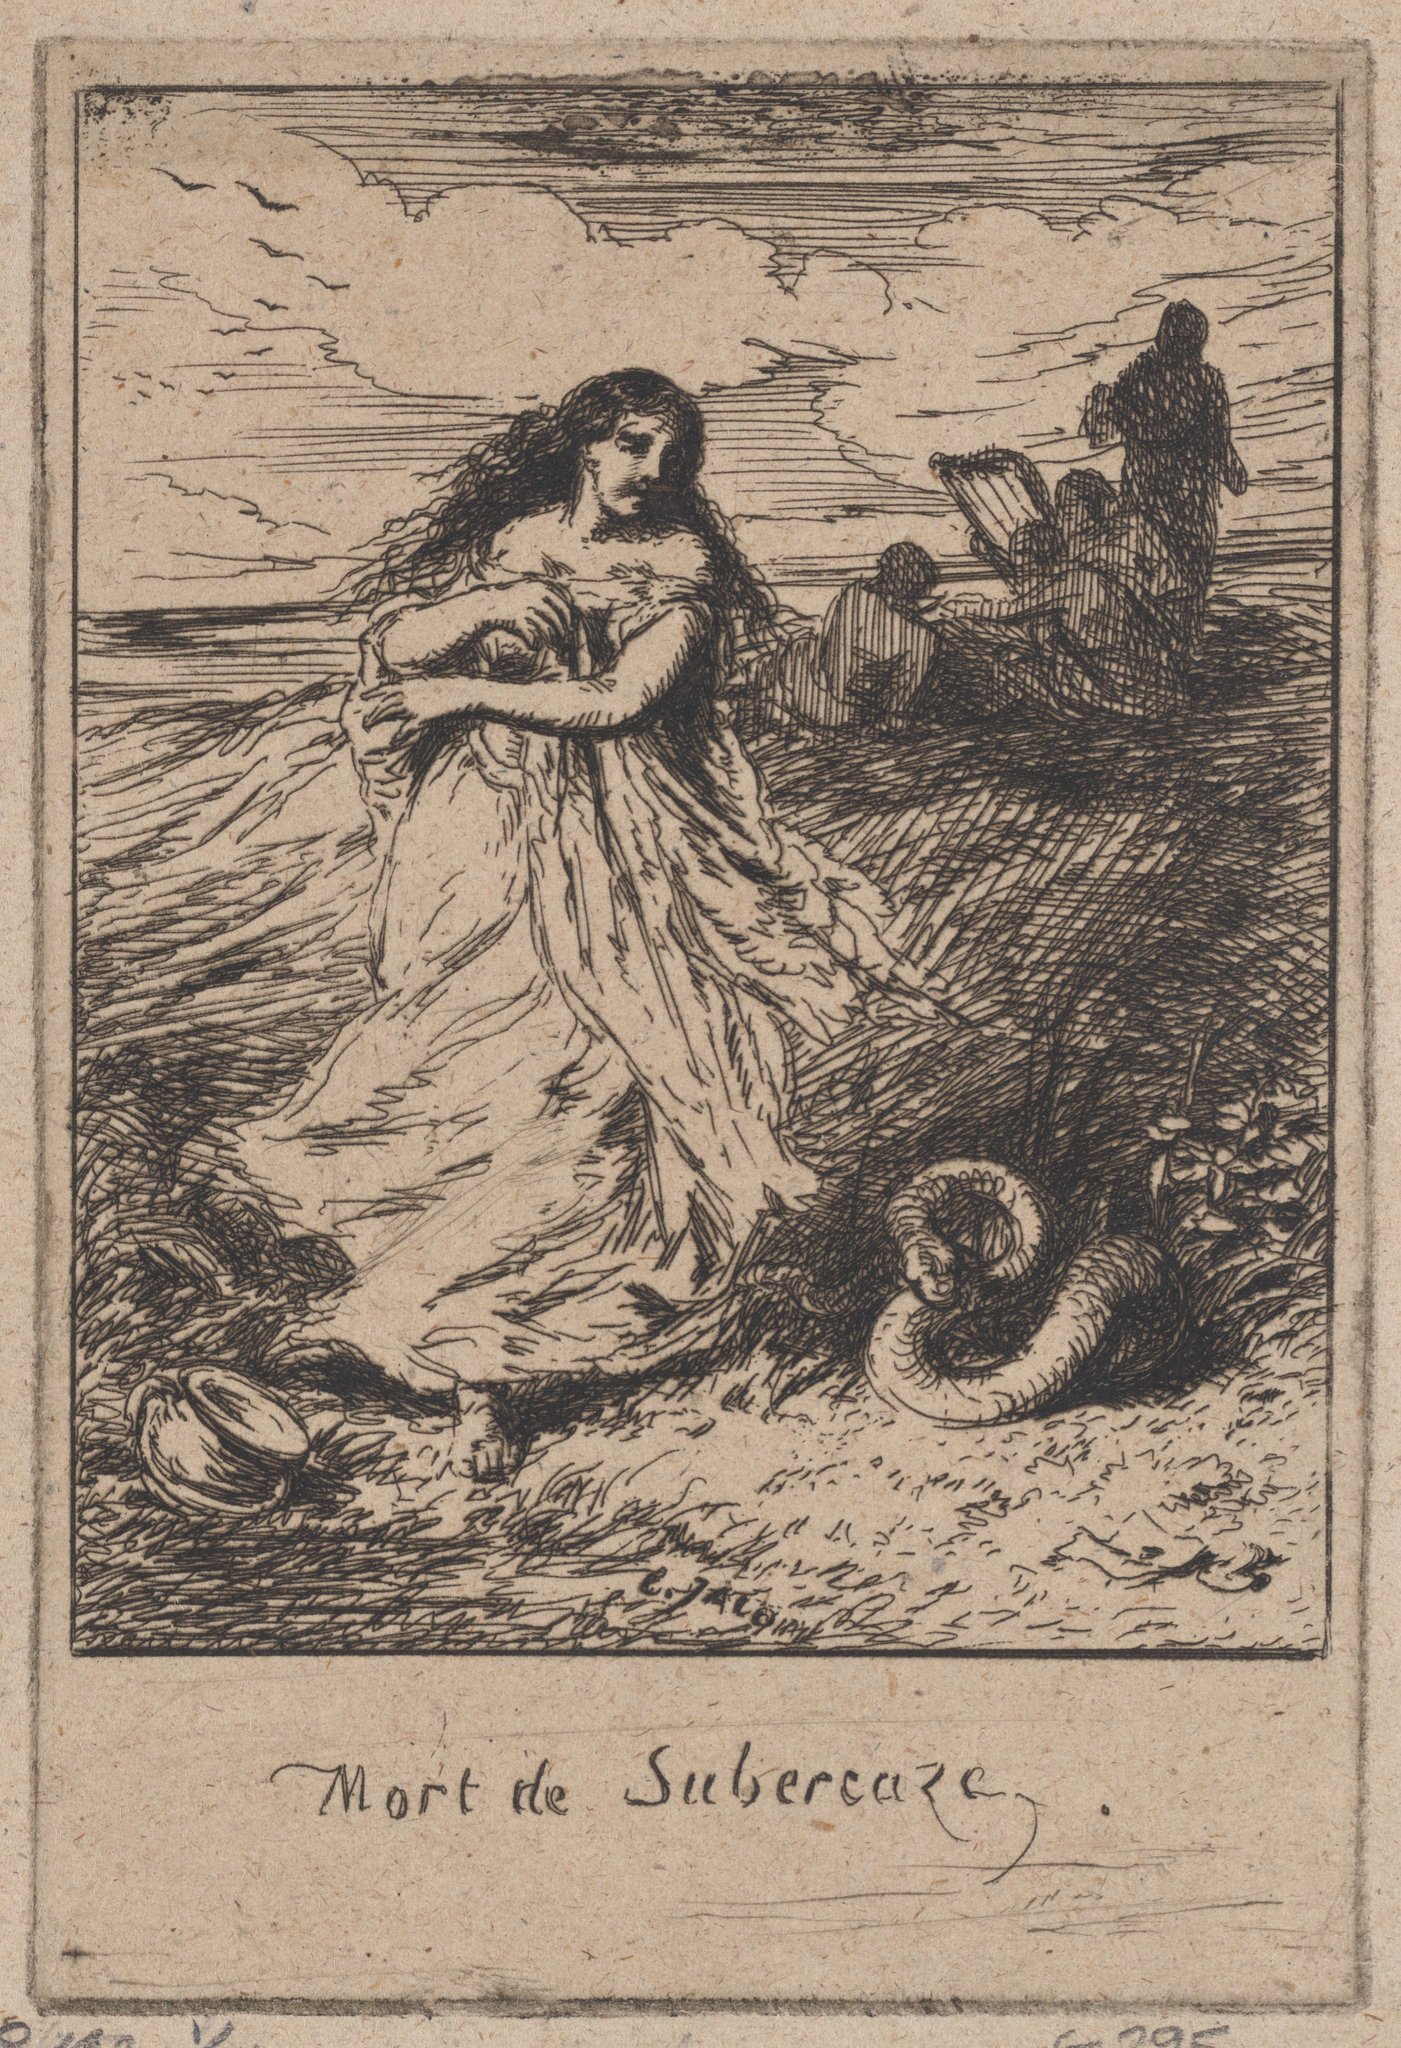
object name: print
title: Death of Subercaze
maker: charles émile jacque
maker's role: artist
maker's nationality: french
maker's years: 1813-1894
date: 1846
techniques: etching